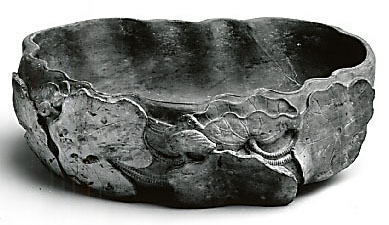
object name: inkstone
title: Water Well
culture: chinese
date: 1301-1400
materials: stone